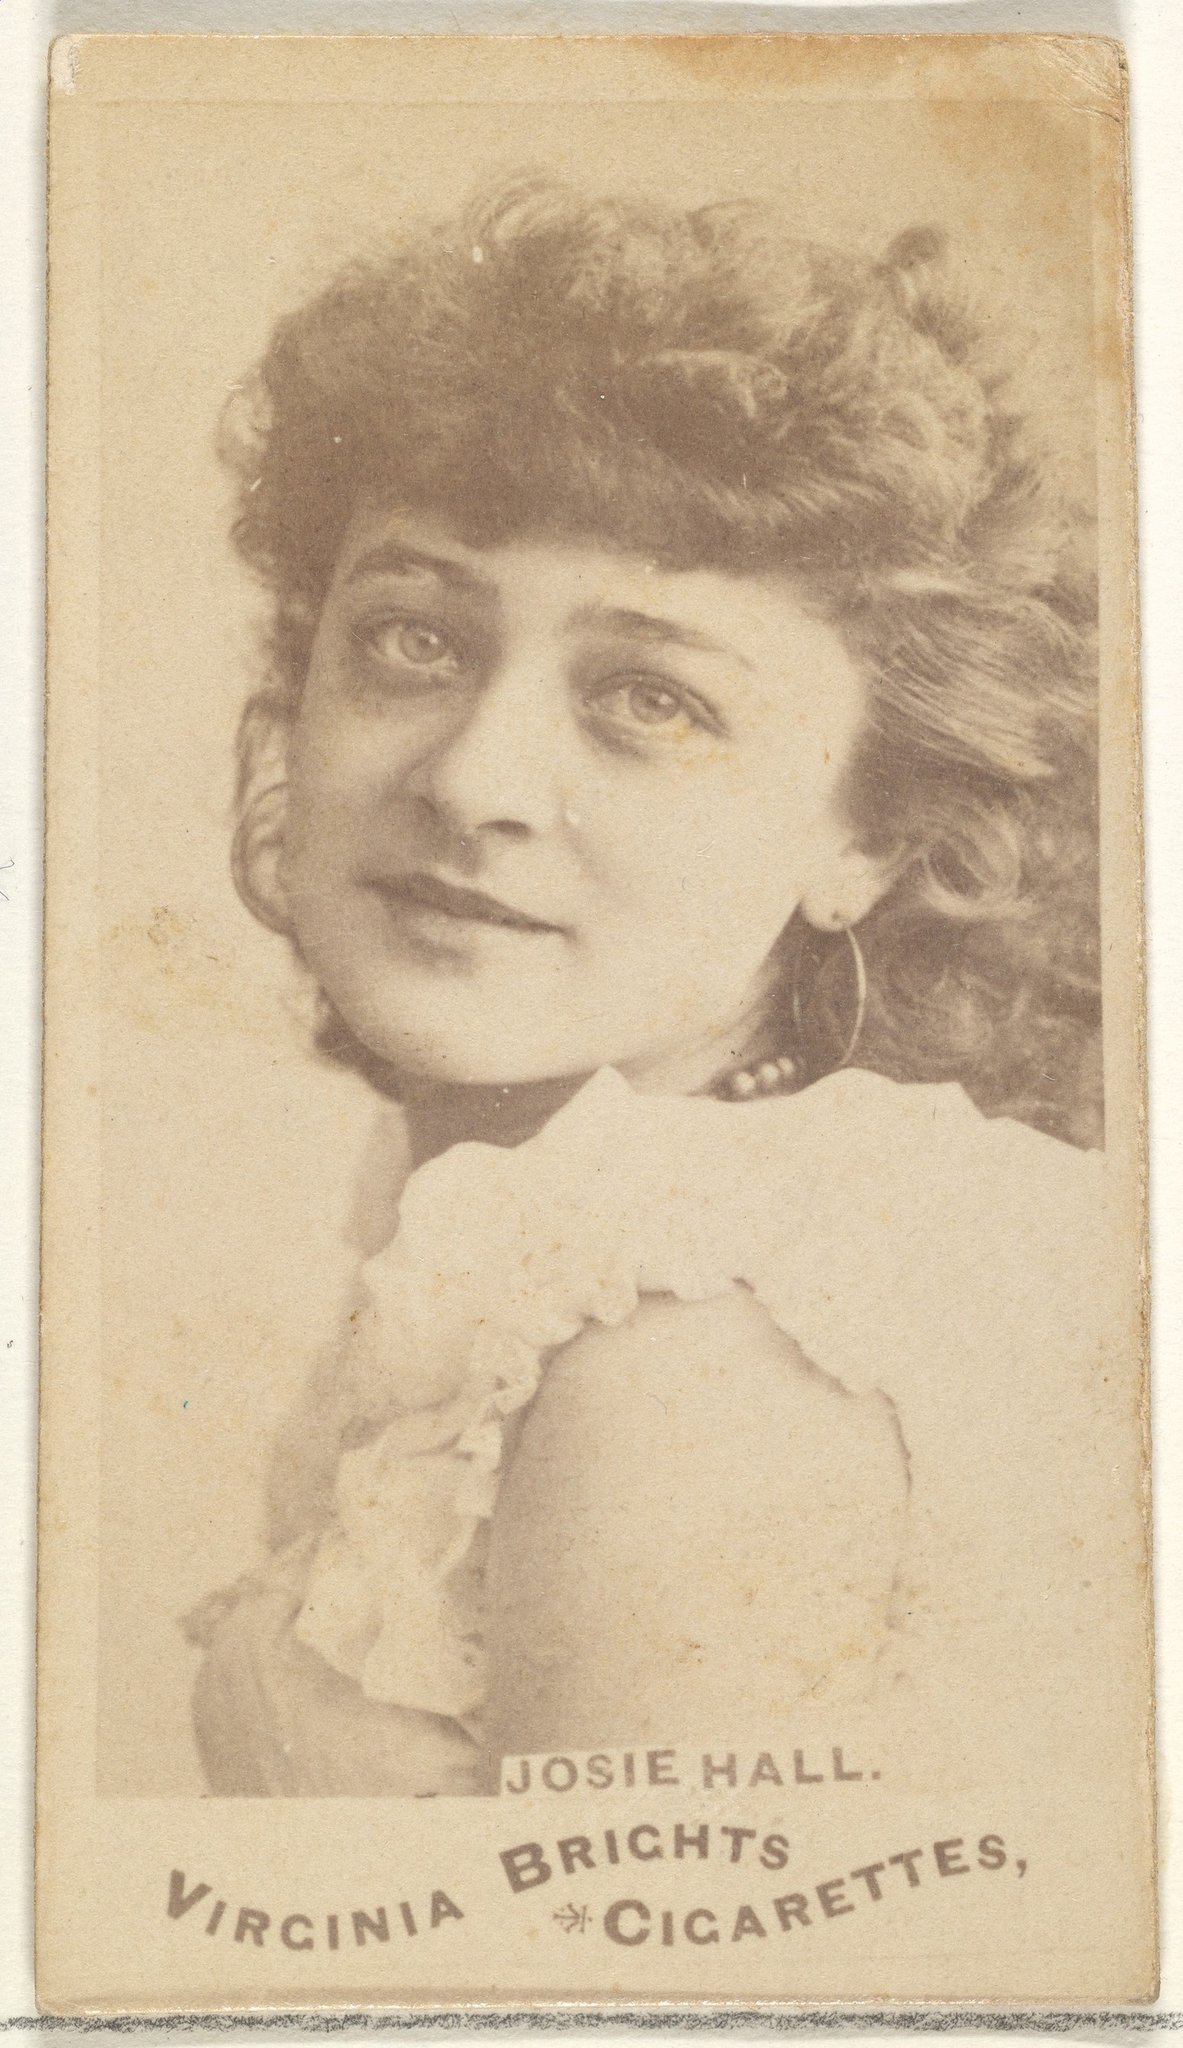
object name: photograph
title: Josie Hall, from the Actors and Actresses series (N45, Type 1) for Virginia Brights Cigarettes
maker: allen & ginter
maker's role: publisher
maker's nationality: american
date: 1888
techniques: albumen silver print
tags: portraits,women,actresses